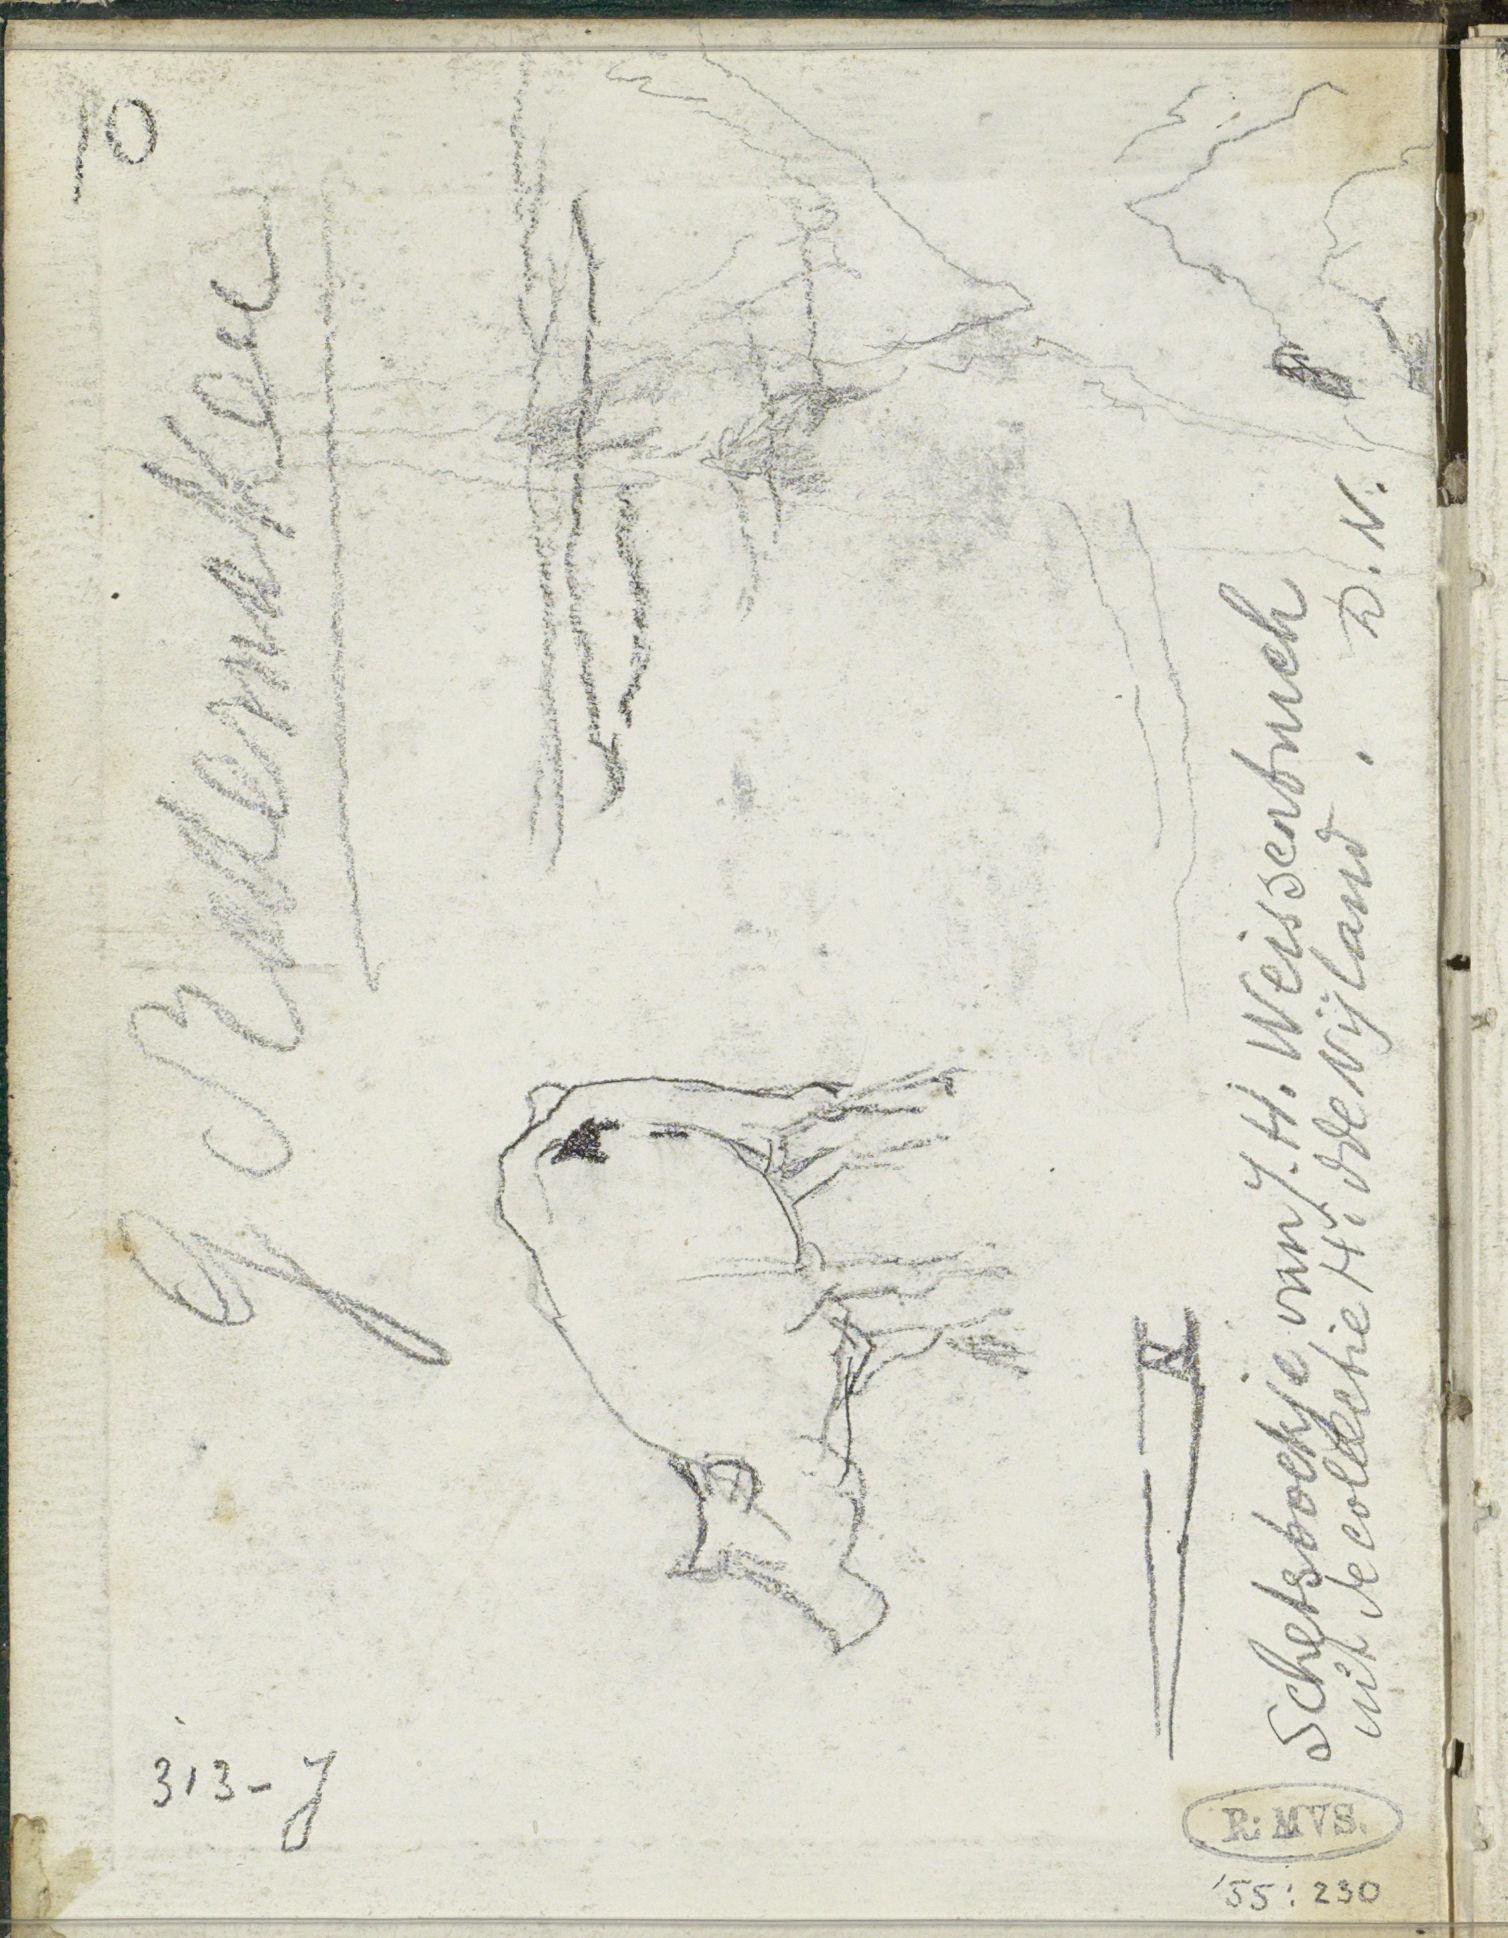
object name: endleaf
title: Koe en een landschap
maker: johan hendrik weissenbruch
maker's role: draughtsman, painter, print maker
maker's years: 1824-1903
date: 1834-1903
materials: paper, pencil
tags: cow, landscapes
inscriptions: annotation: ‘schetsboekje van J.H. Weissenbruch/ uit collectie Hiddenijland/ D.N.’, collector's mark: Lugt 2228a, annotation: ‘G Rademaker’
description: Voorste schutblad uit een schetsboek met 34 bladen.